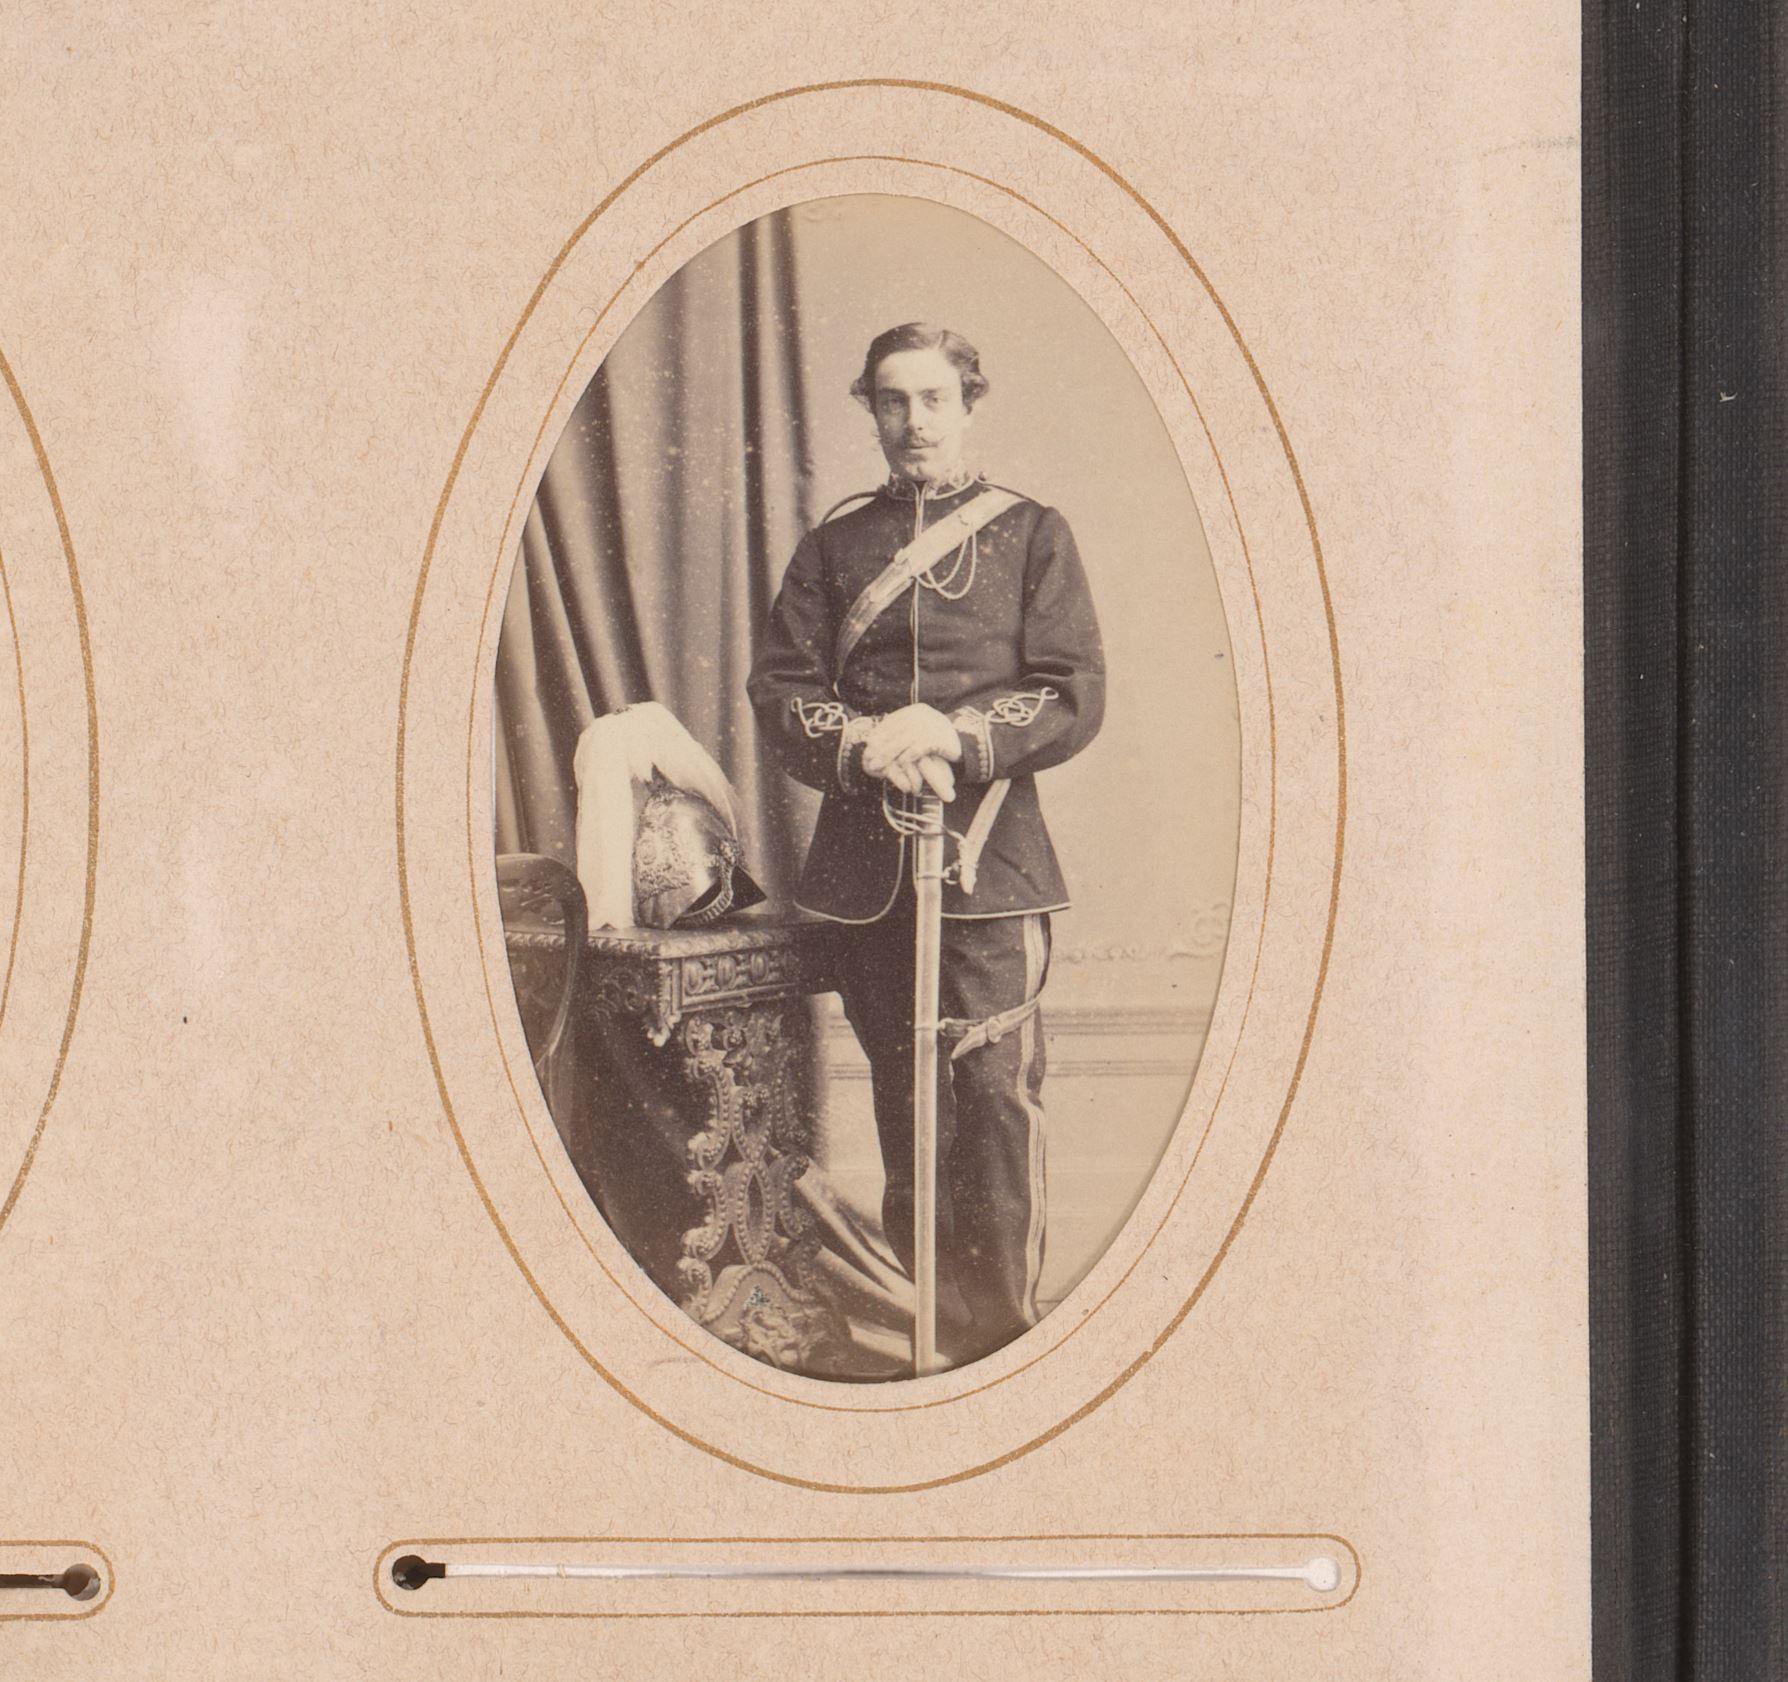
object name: carte de visite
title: Portret van een man in uniform met helm en zwaard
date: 1860-1890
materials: cardboard, photographic support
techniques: albumen print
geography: england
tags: helmet, historical persons, hacking and thrusting weapons: sword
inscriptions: inscription: ‘Sawyer's Italian Studios/ Norwich/ 46, London St./ Ipswich/ 18, Brook St.’